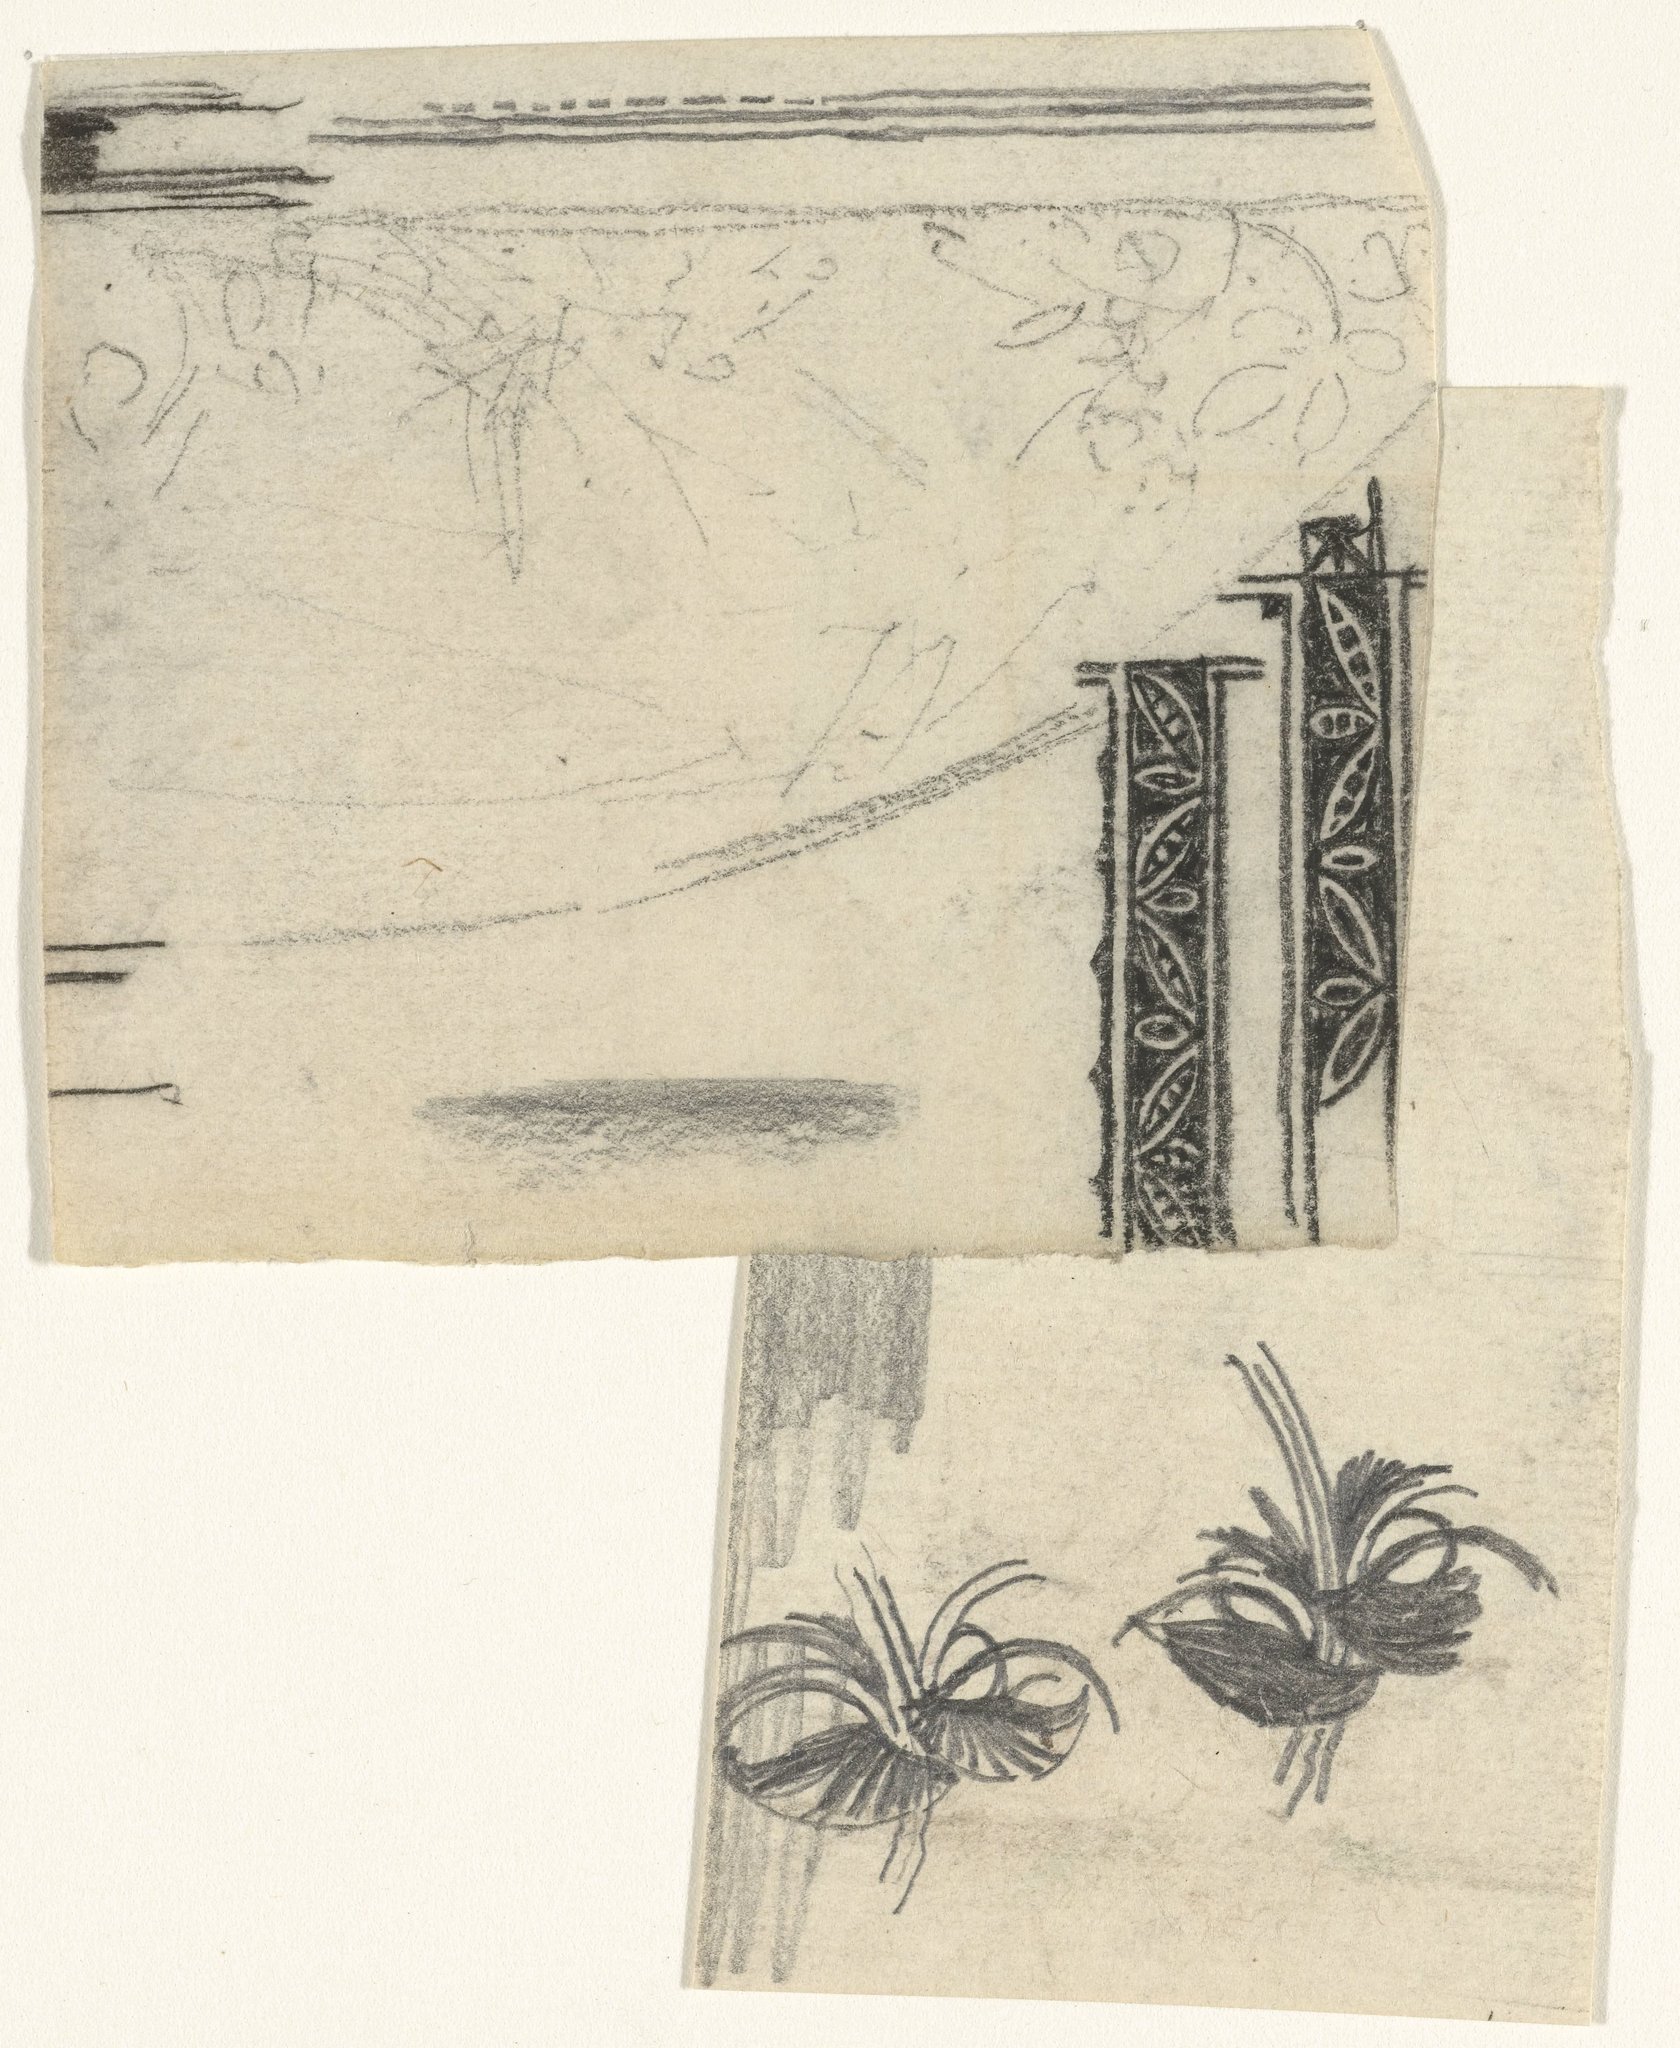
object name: drawing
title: Schetsen van randwerk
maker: gerrit willem dijsselhof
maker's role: designer, draughtsman, print maker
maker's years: 1866-1924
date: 1876-1901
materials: chalk, paper, pencil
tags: ornament derived from plant forms